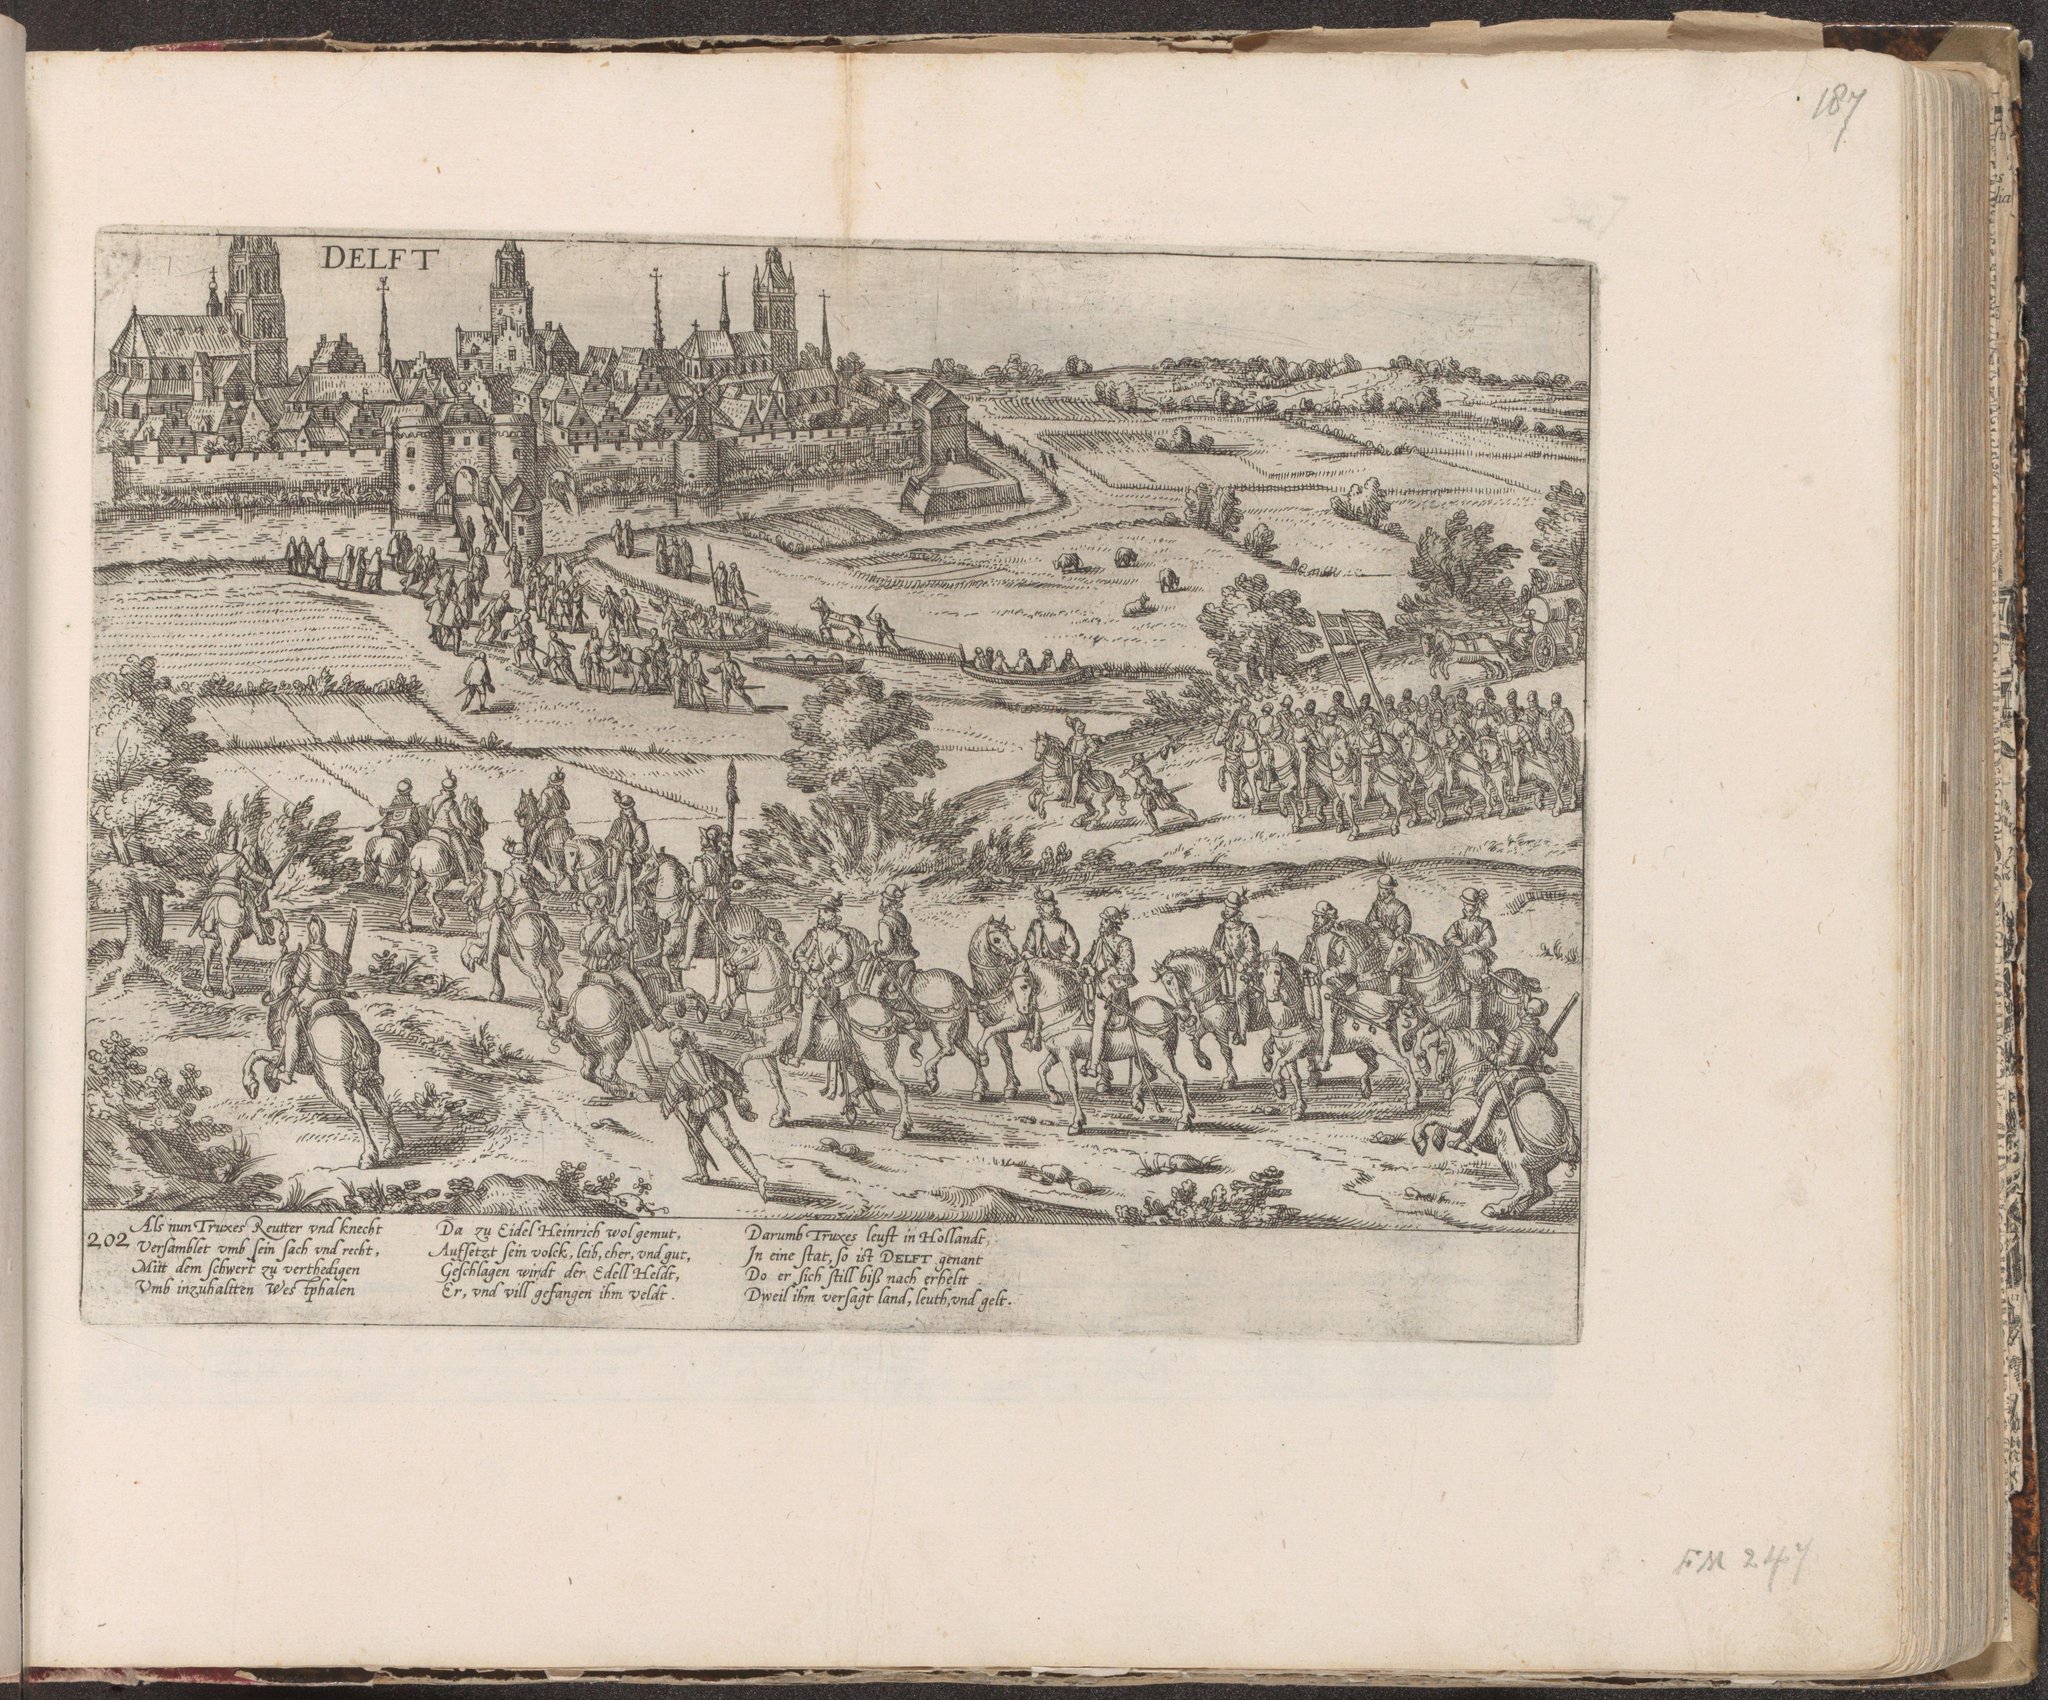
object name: print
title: Serie 9: Nederlandse en Duitse Gebeurtenissen, 1583-1587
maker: frans hogenberg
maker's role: print maker, publisher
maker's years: 1538-1590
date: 1587-1591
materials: paper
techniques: etching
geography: cologne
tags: delft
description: Gebhard Truchsess trekt in stoet met troepen richting Delft, 20 april 1584. Episode uit de Keulse Oorlog. Met onderschrift van 12 regels in het Duits. Linksonder genummerd: 202. De prent maakt deel uit van een album.